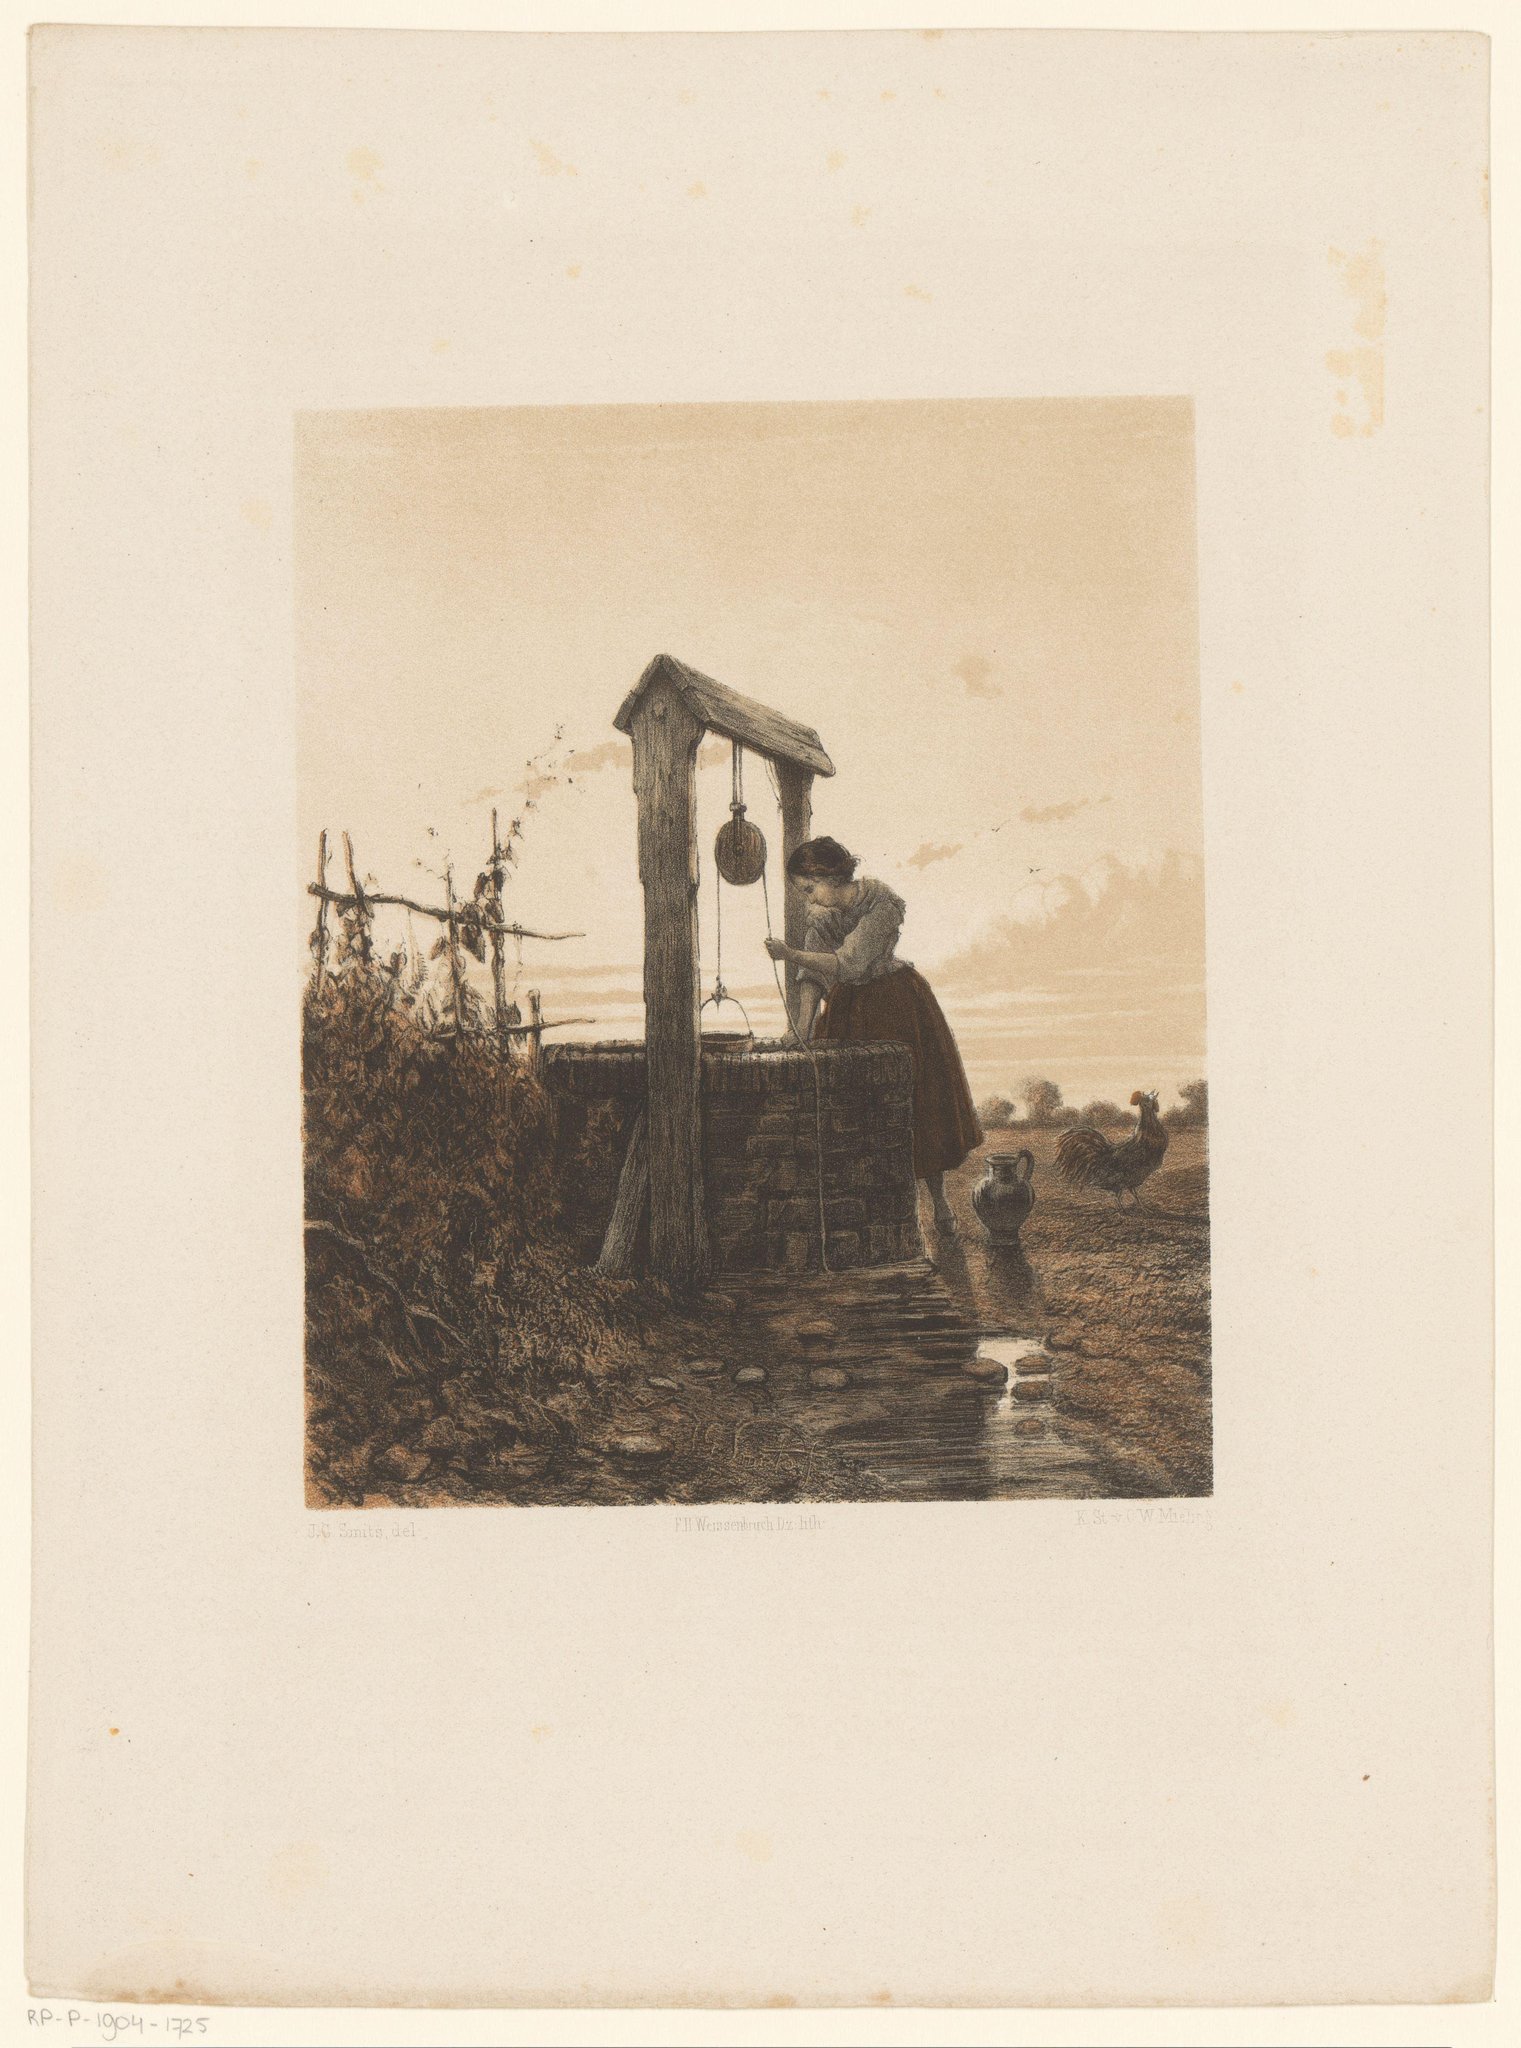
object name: print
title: Vrouw bij waterput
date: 1853-1865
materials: paper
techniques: lithograph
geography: the hague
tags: well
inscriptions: collector's mark: Lugt 2228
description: Een jonge vrouw staat bij een waterput en laat haar emmer naar beneden zakken. Naast haar staan een kan en een haan. In de achtergrond de opkomende of ondergaande zon.